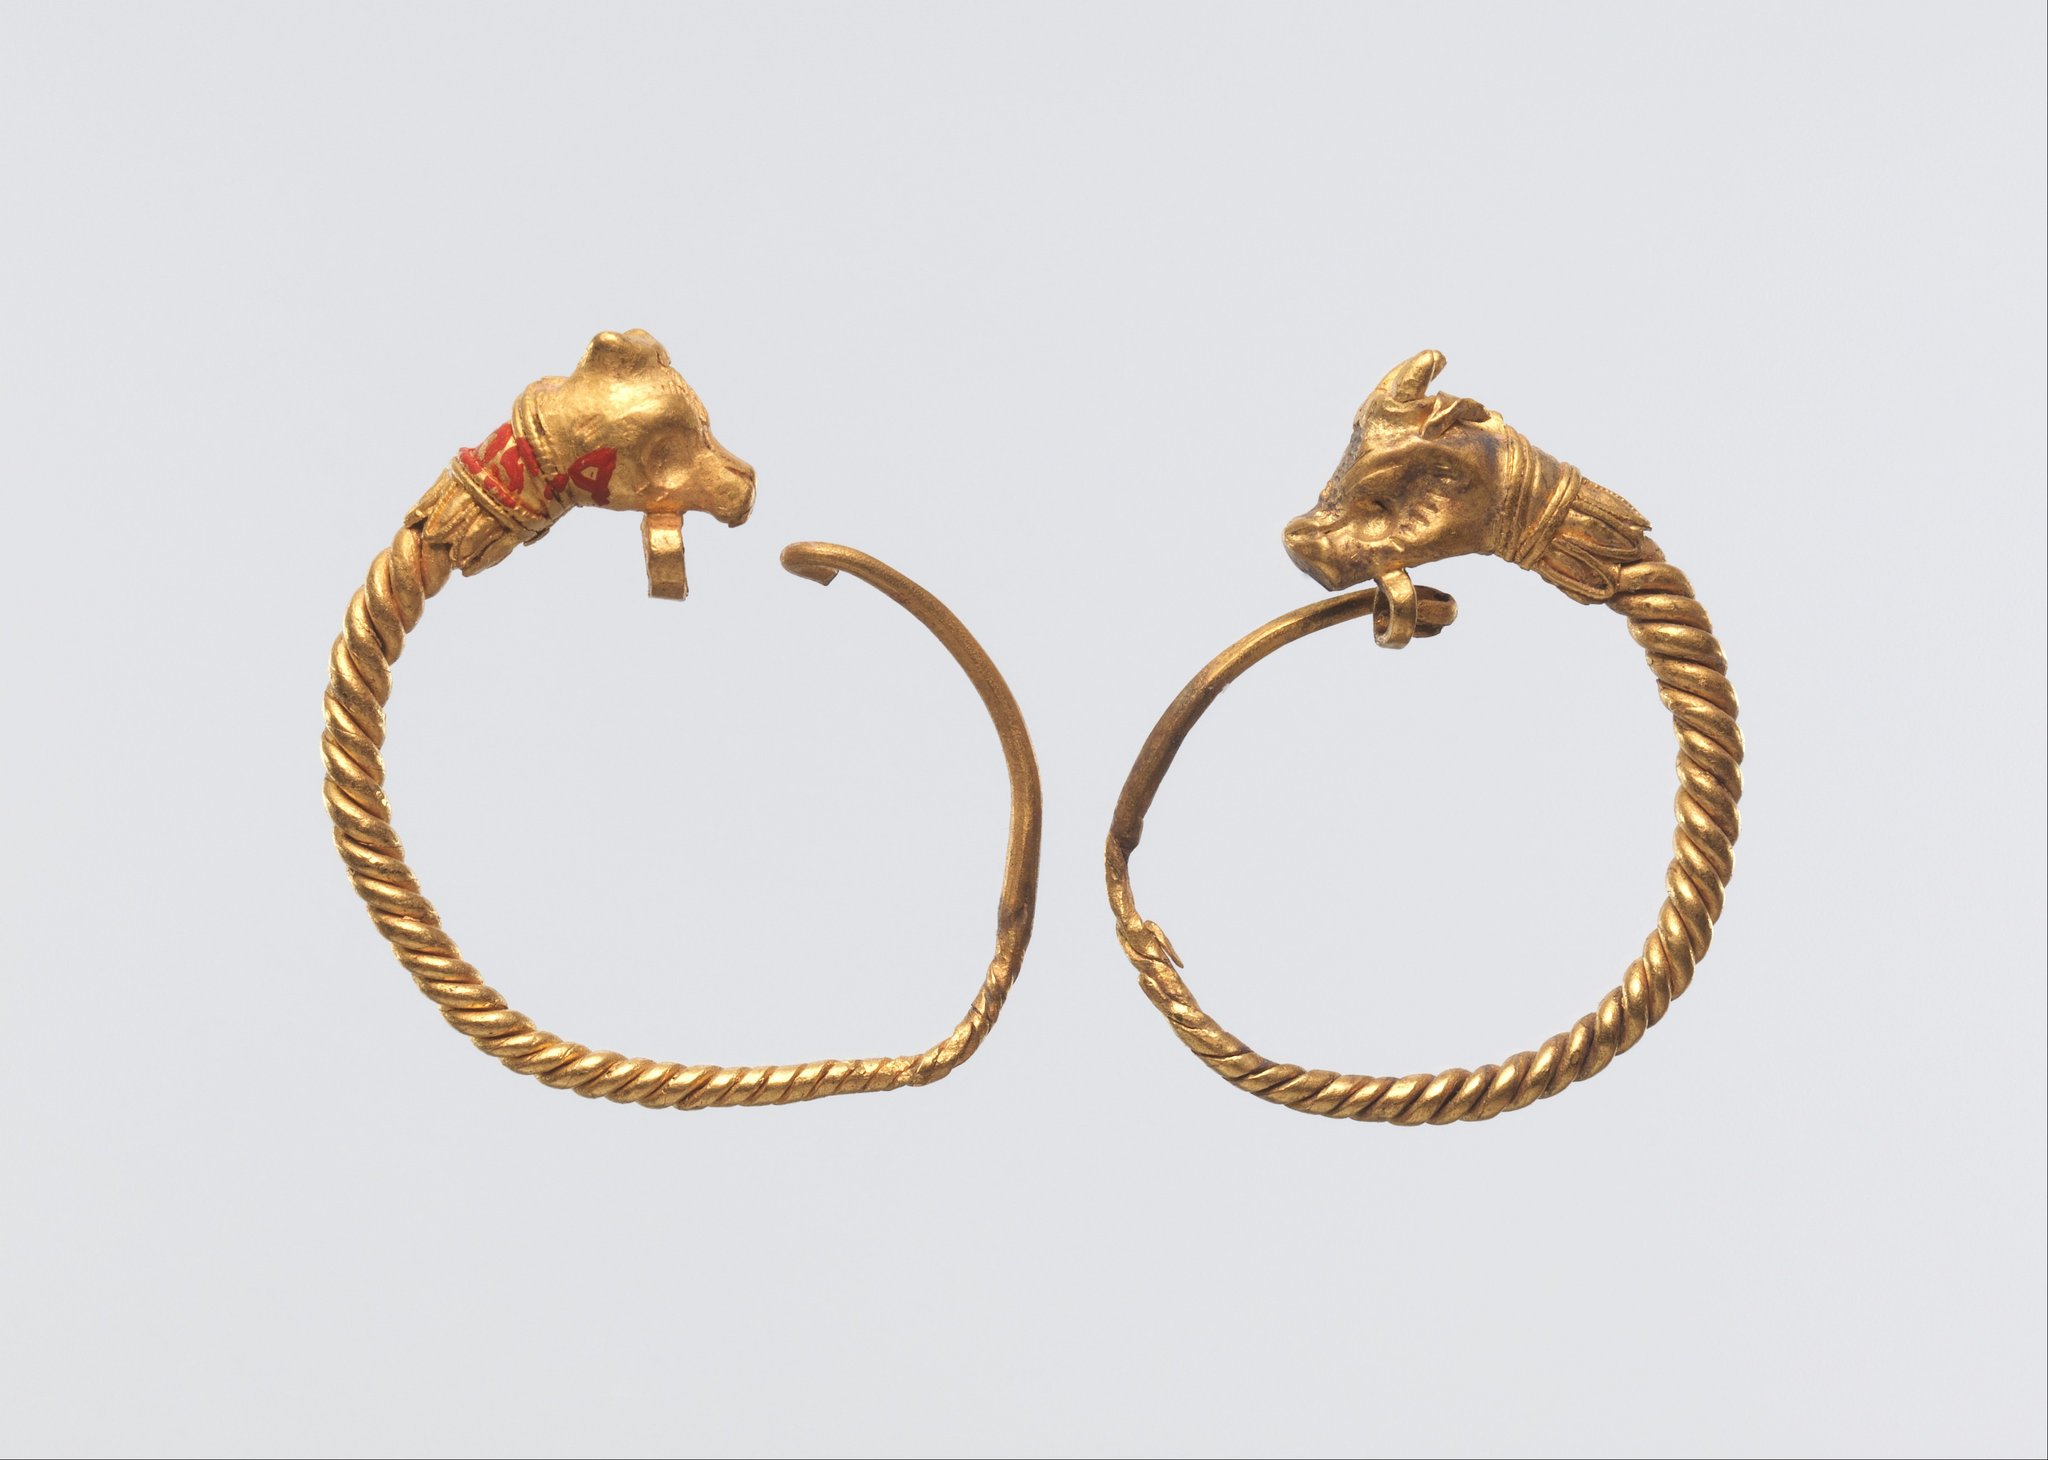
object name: earring, bull head terminal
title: Earrings with bull head terminal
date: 400-201 BCE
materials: gold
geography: egypt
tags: bulls